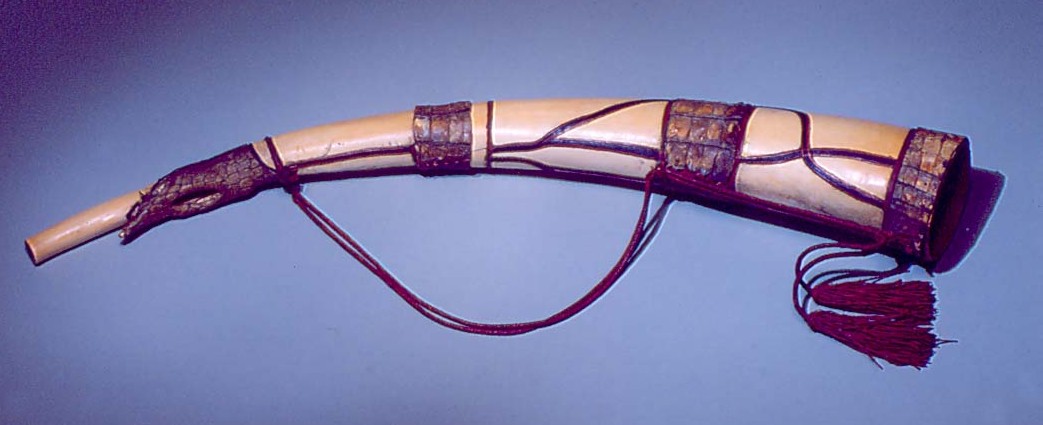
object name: horn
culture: congolese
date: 1867-1900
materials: ivory, leather, skin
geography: democratic republic of congo